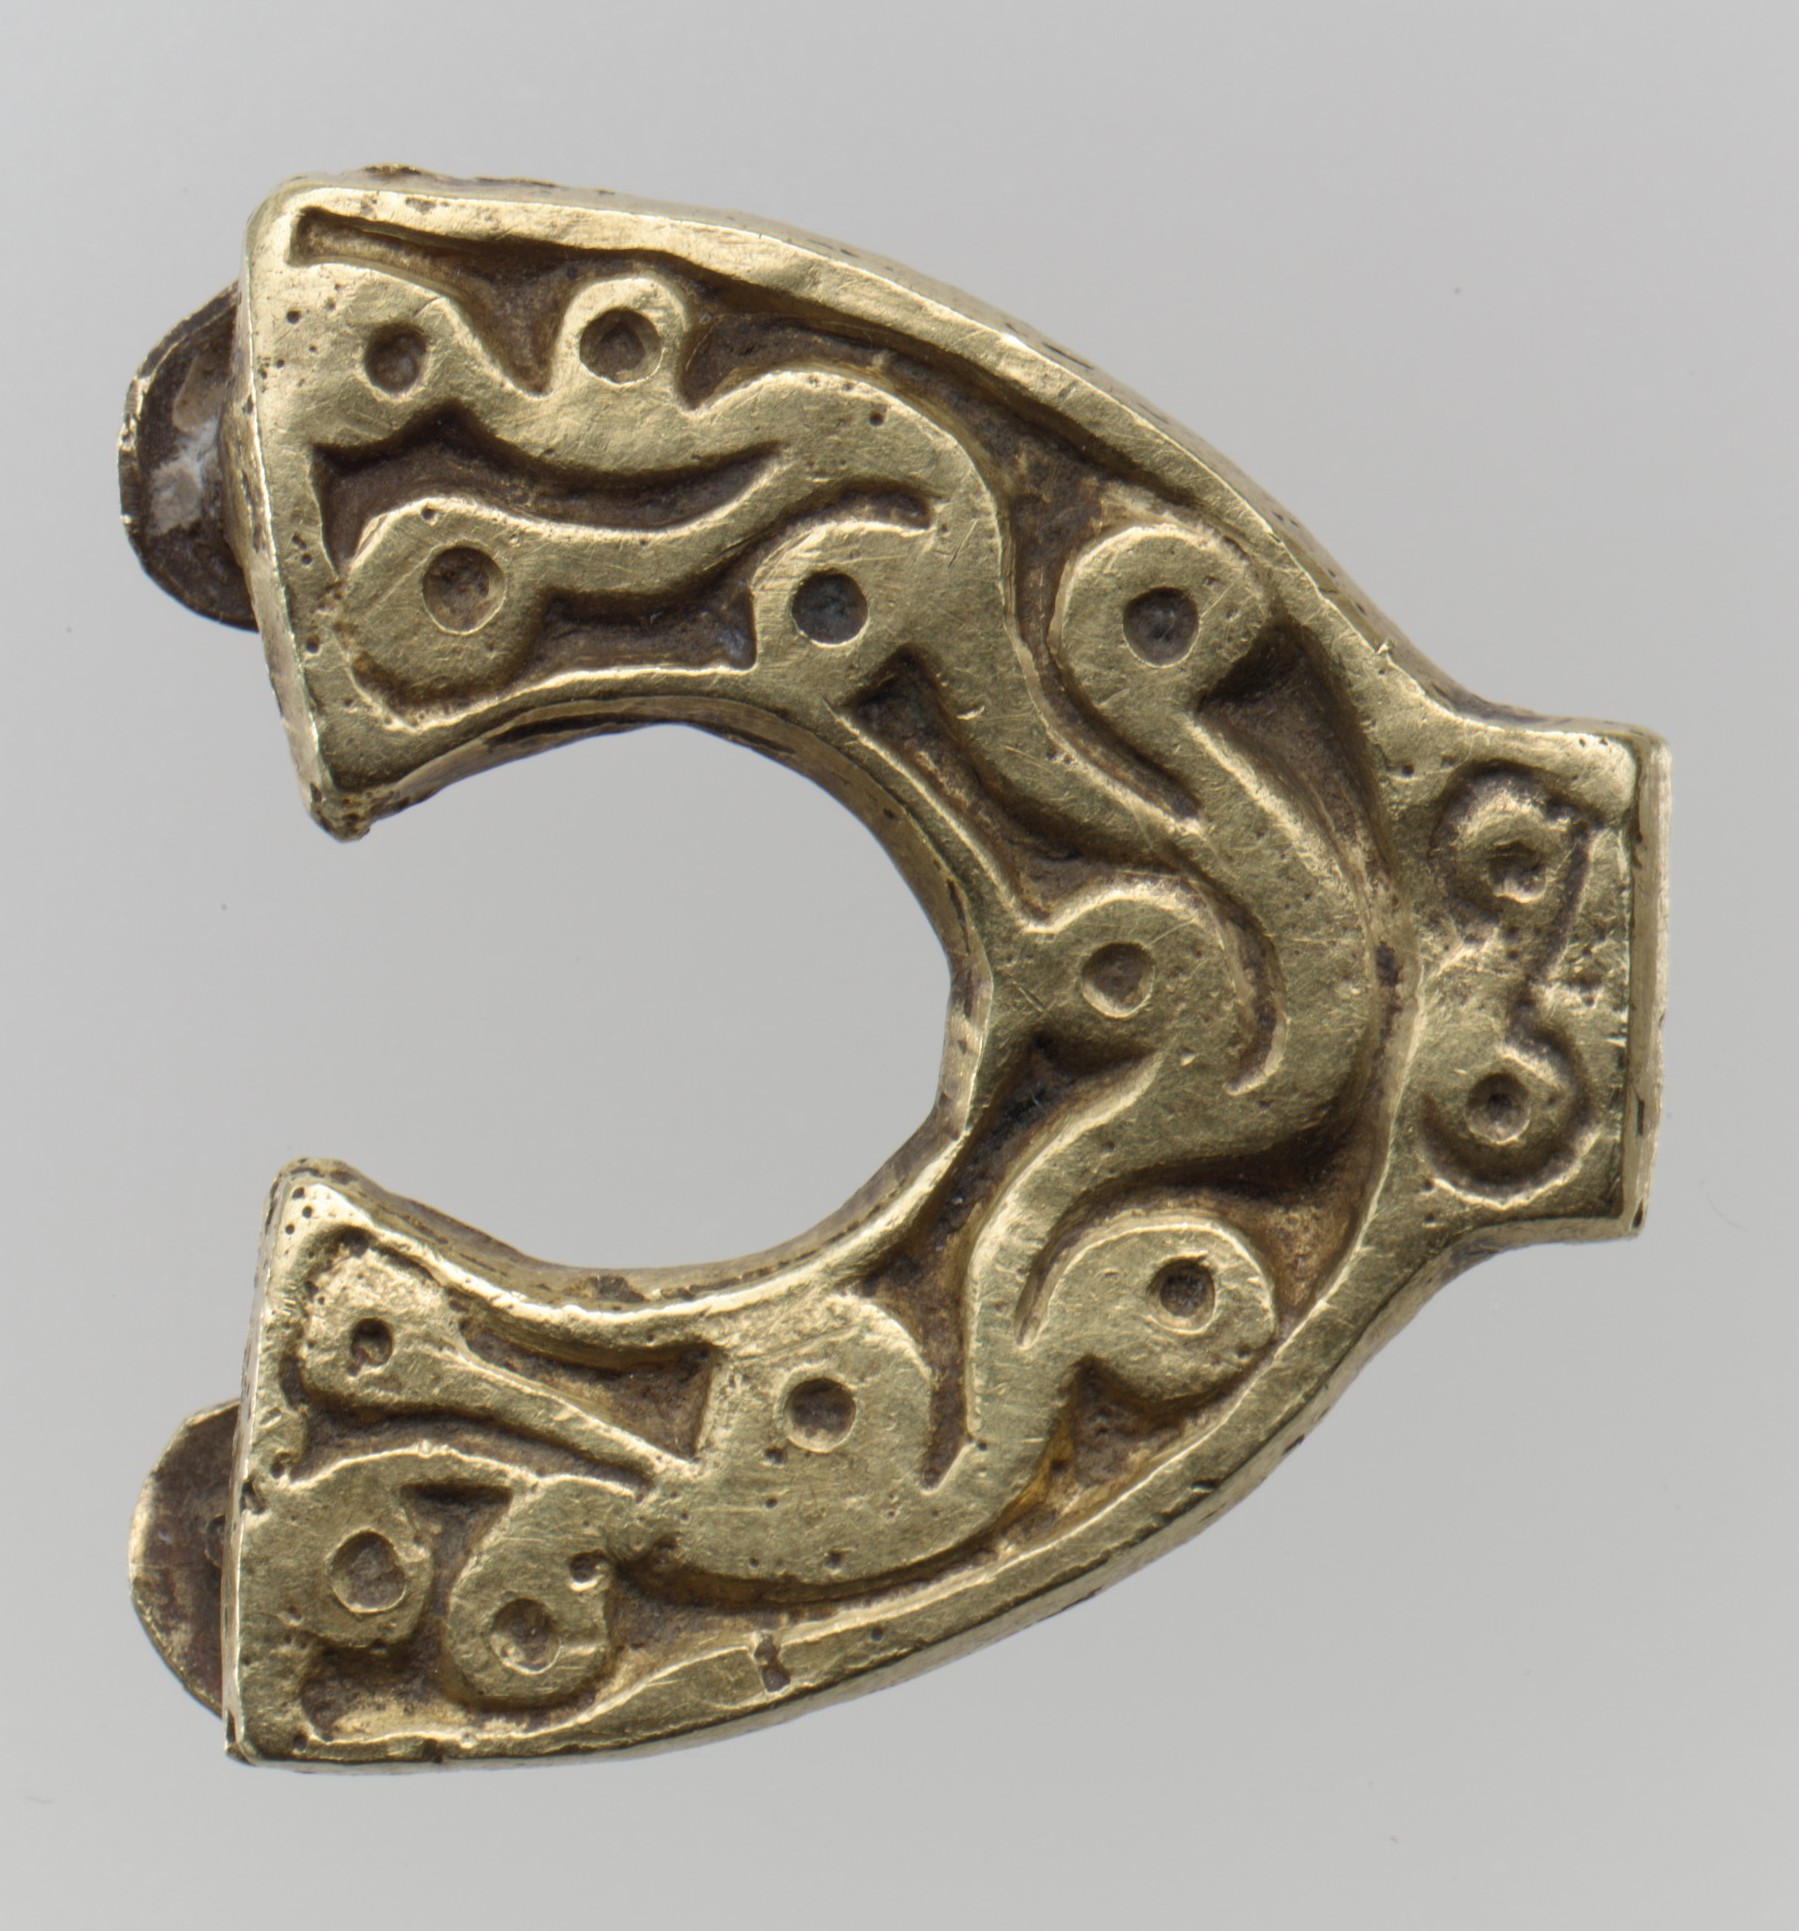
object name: belt hole guard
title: Gold Belt Hole Guard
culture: avar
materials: gold